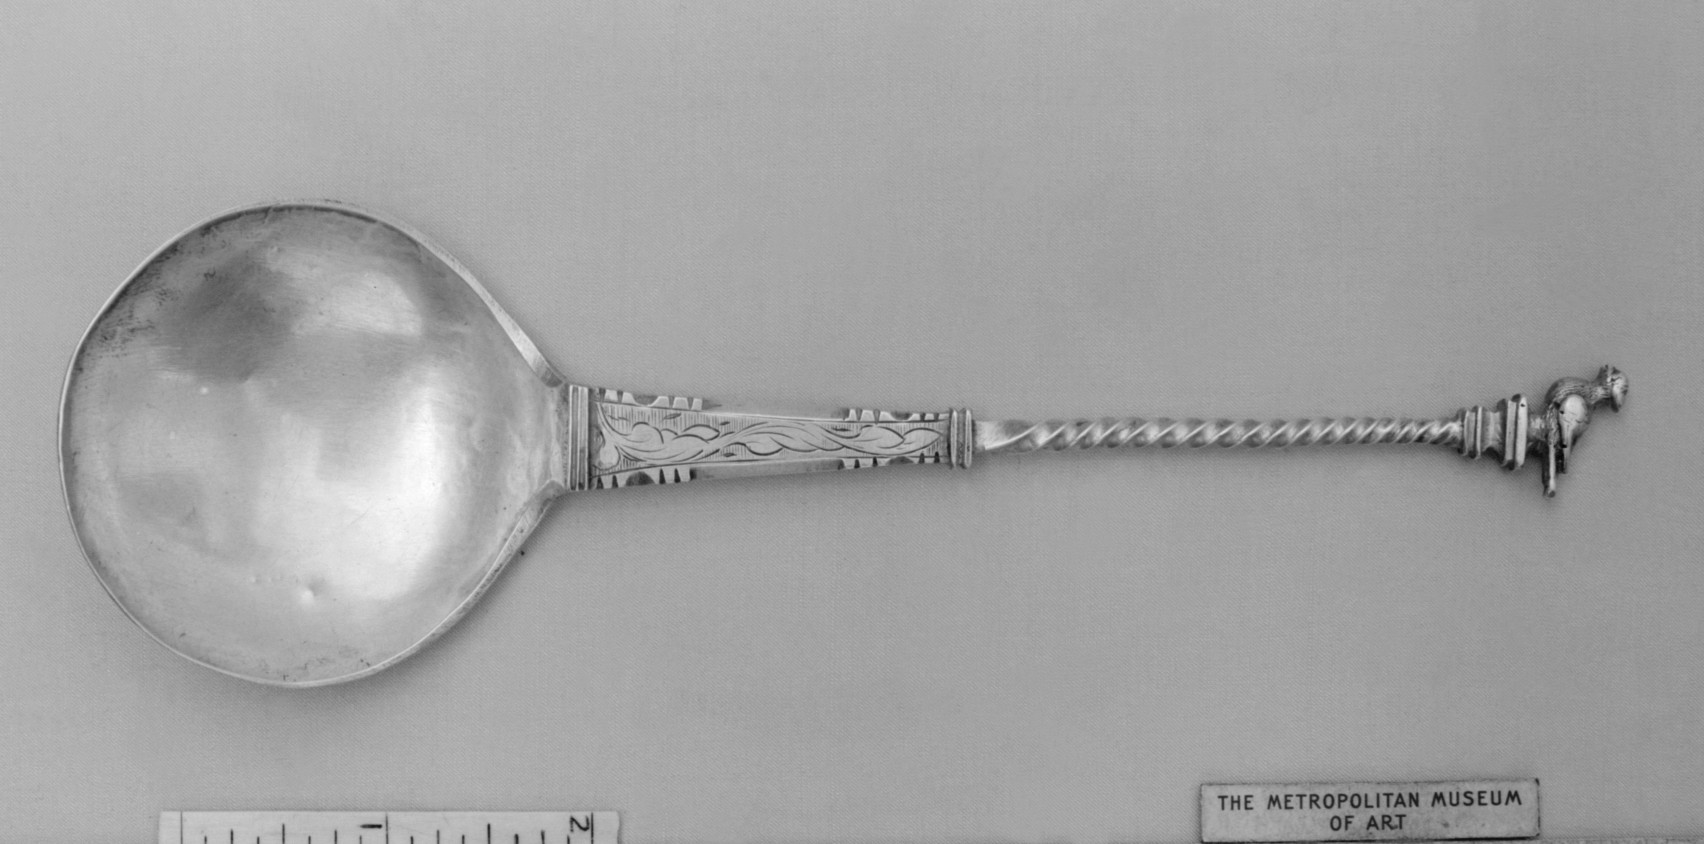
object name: spoon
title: Figure-top spoon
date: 1683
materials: silver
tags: birds